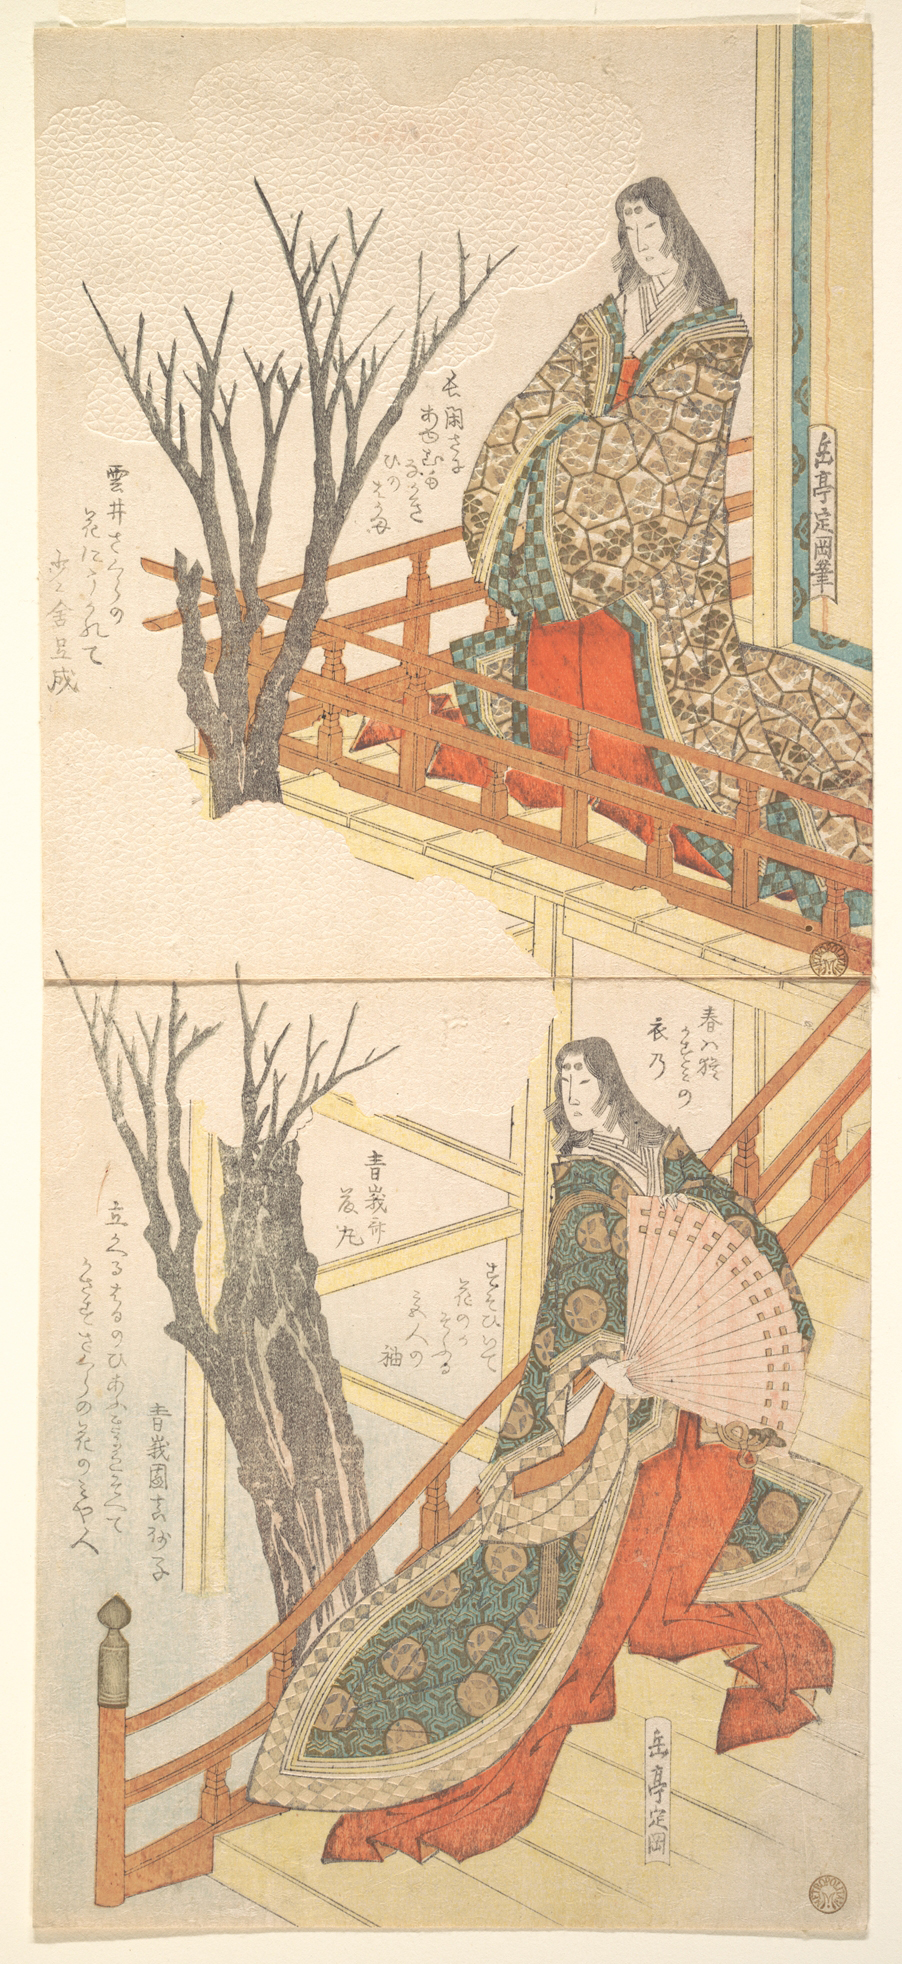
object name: print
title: Two Court Ladies Admire the Cherry Trees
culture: japanese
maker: yashima gakutei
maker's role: artist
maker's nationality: japanese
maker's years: 1786-1868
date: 1820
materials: ink, paper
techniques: surimono, woodblock print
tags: fans,women,trees